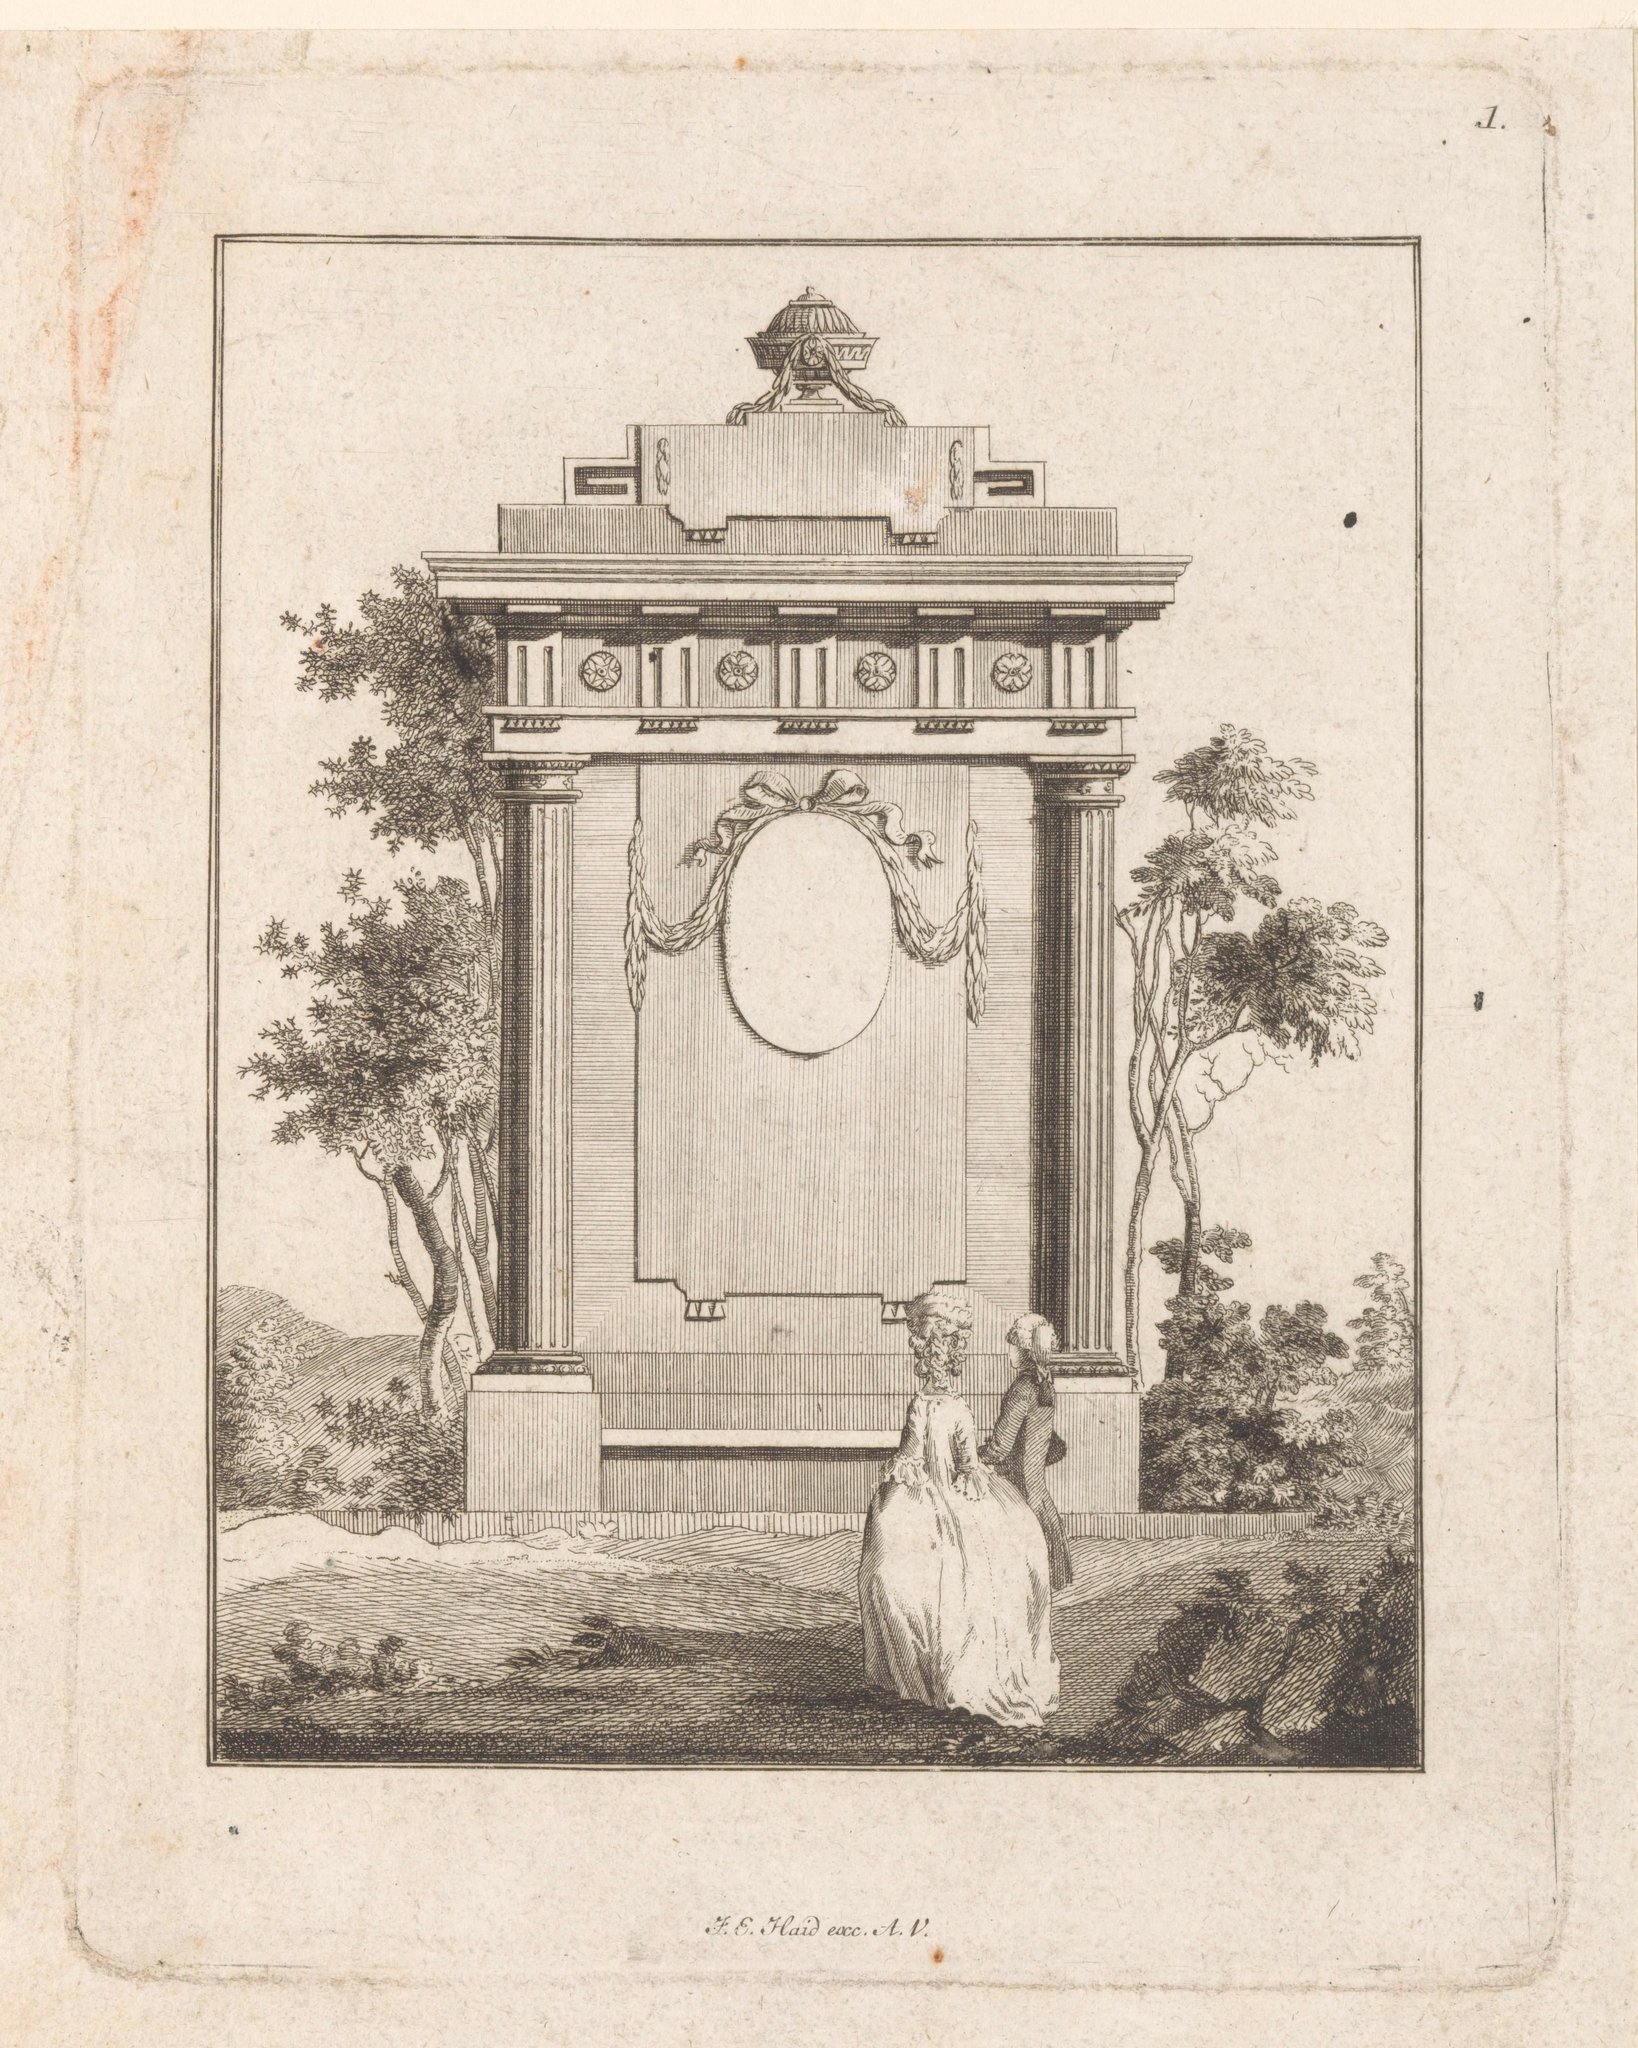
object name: print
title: Grafmonument met ovaal medaillon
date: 1785-1786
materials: paper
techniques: engraving, etching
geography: augsburg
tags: ornament ~ medallion, grave, tomb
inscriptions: collector's mark: Lugt 2228, collector's mark: Lugt 2760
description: Ontwerp voor een grafmonument met ovaal medaillon, guirlandes en een vaas in een landschap. Op de voorgrond een man en een vrouw.